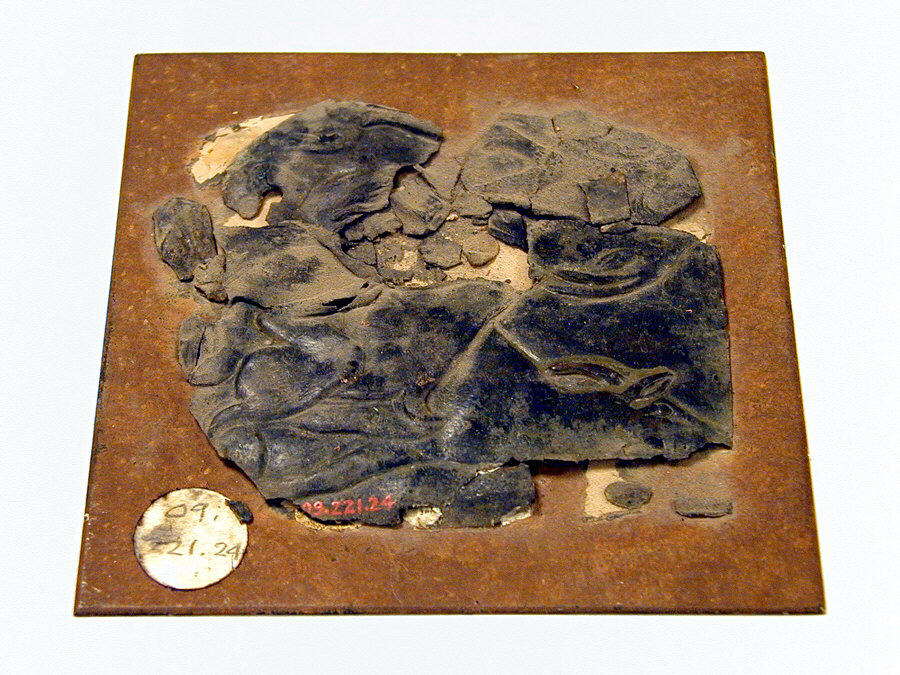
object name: relief of goat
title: Relief of goats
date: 7000 BCE-330 CE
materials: bronze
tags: goats